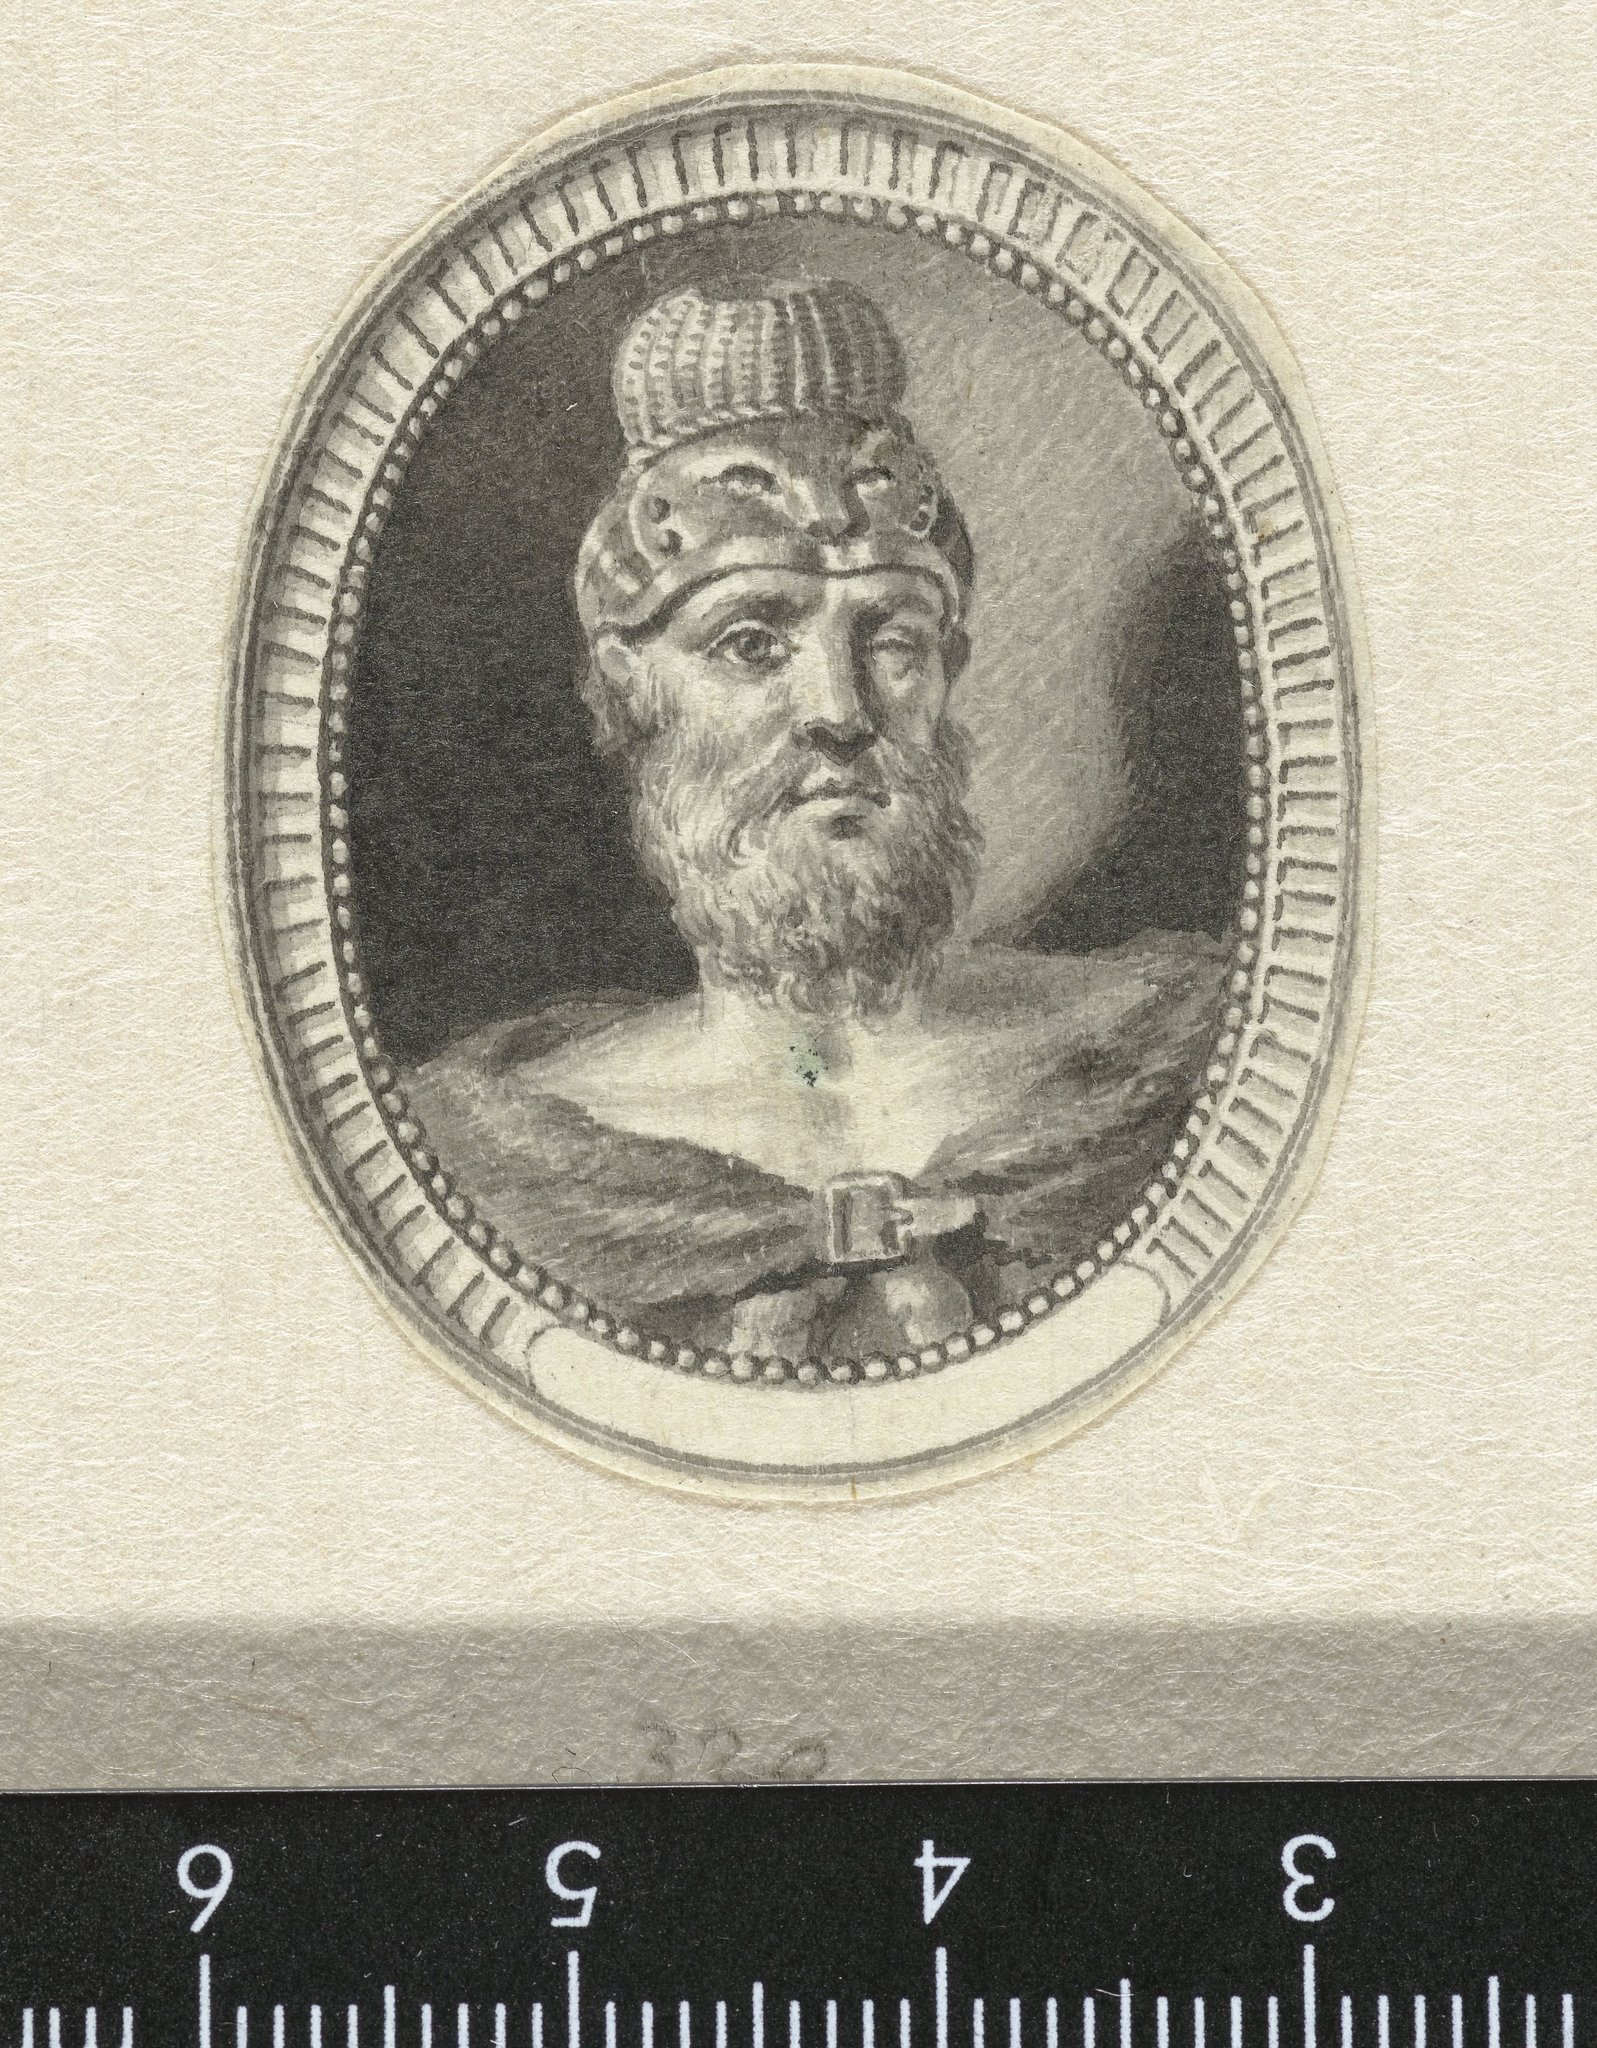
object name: drawing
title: Ovaal portret van een Batavier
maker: jacques kuyper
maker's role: draughtsman, print maker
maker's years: 1761-1808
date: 1771-1808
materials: ink, paper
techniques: brush, pen